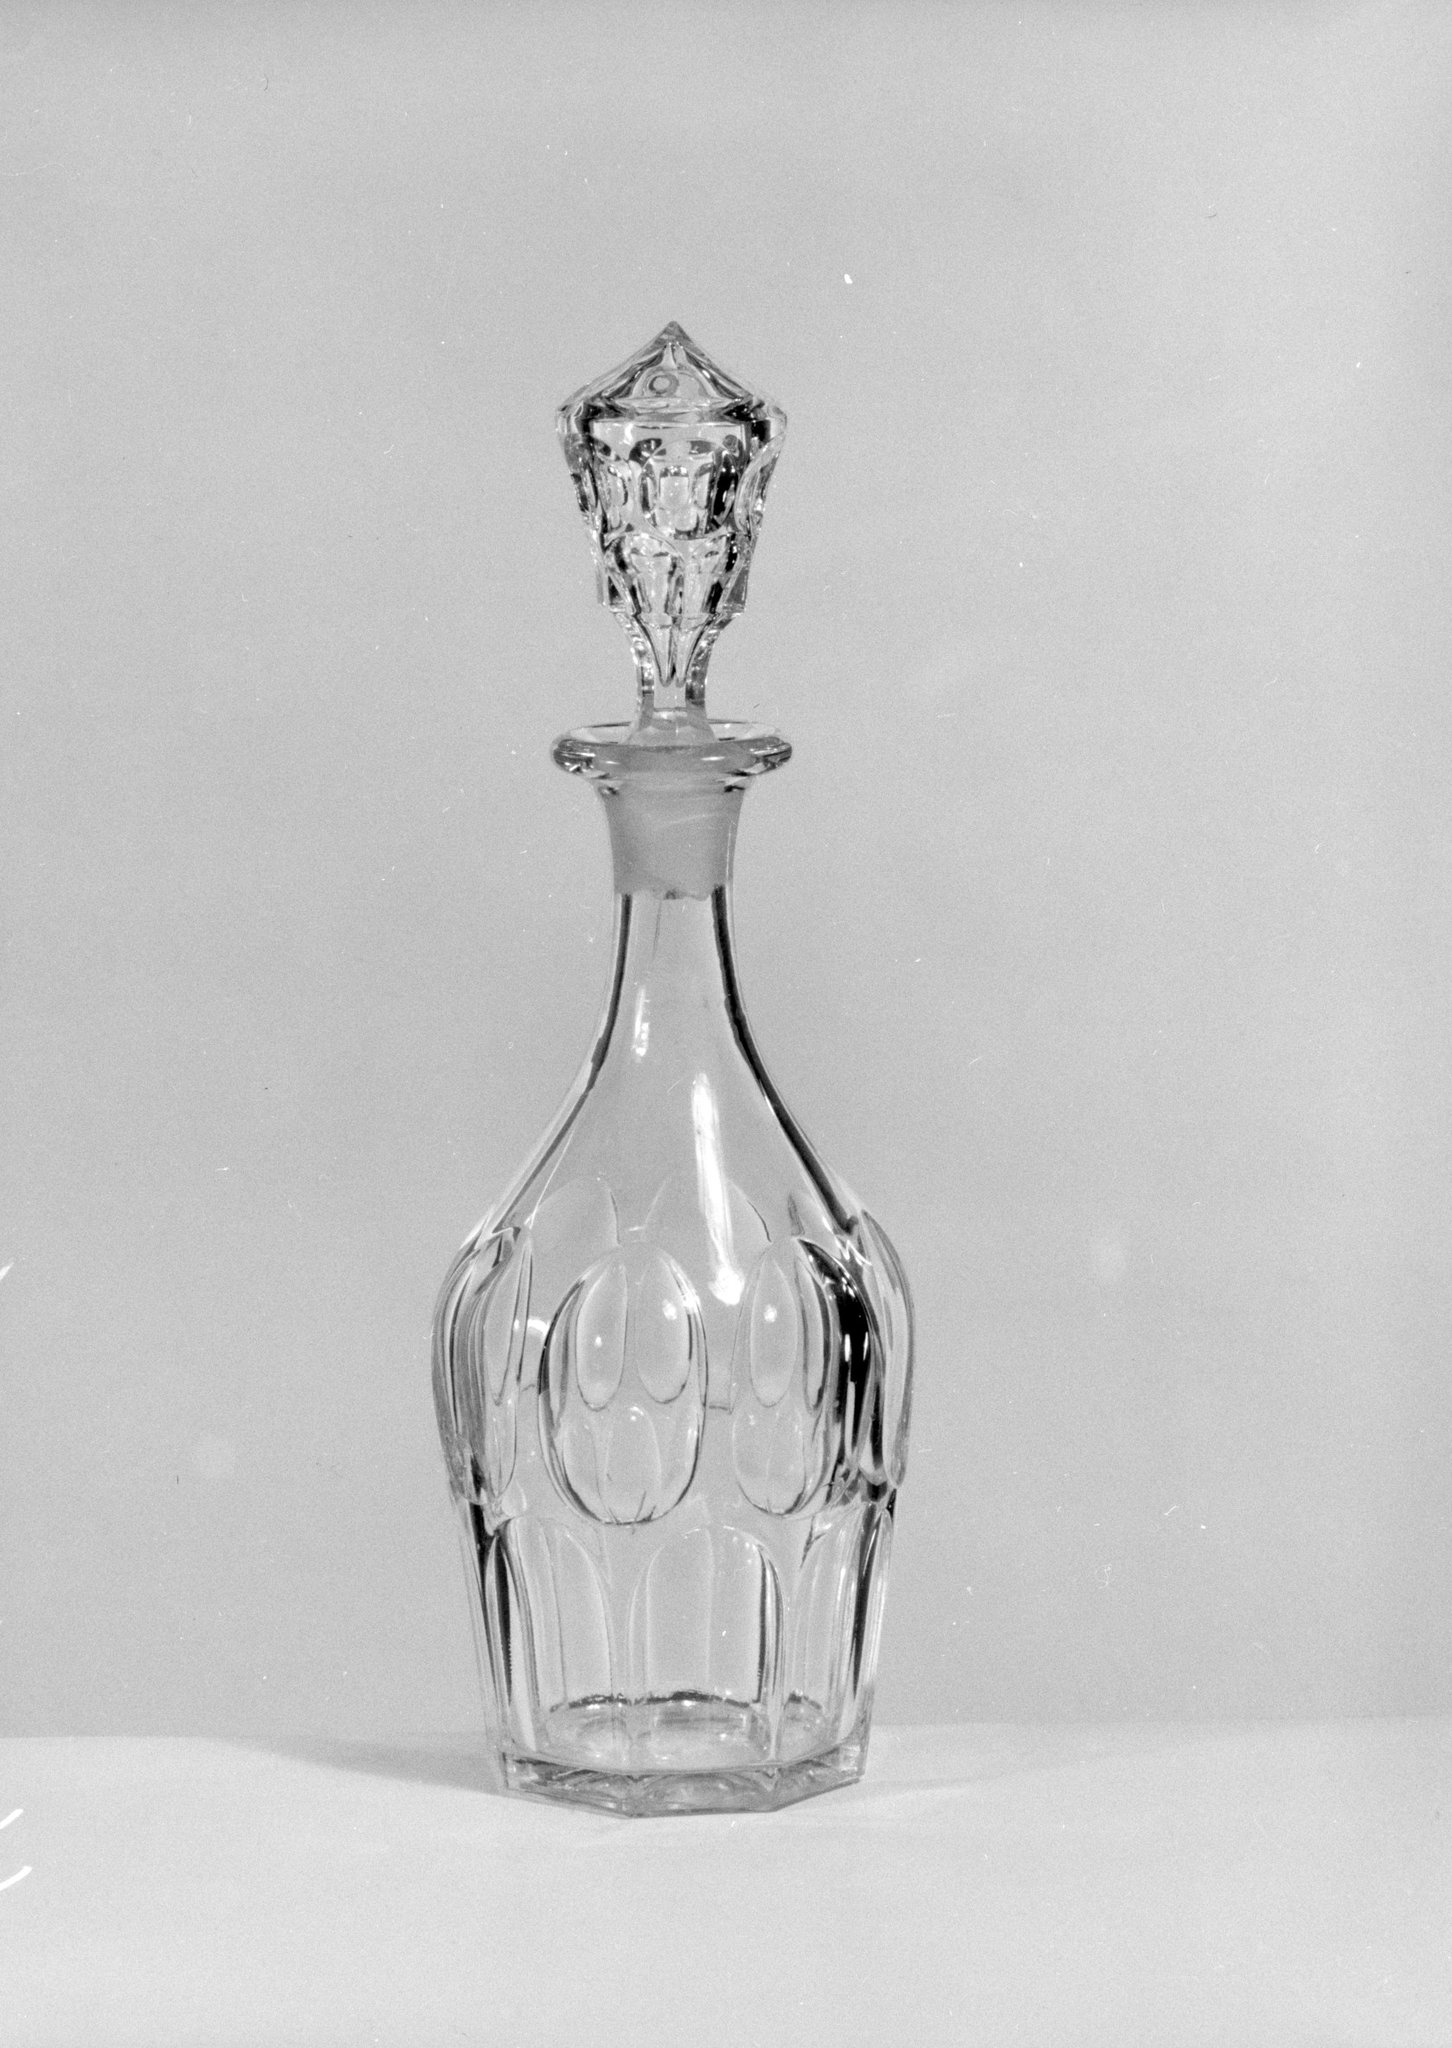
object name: pint decanter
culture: american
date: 1830-1870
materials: glass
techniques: pressed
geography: united states